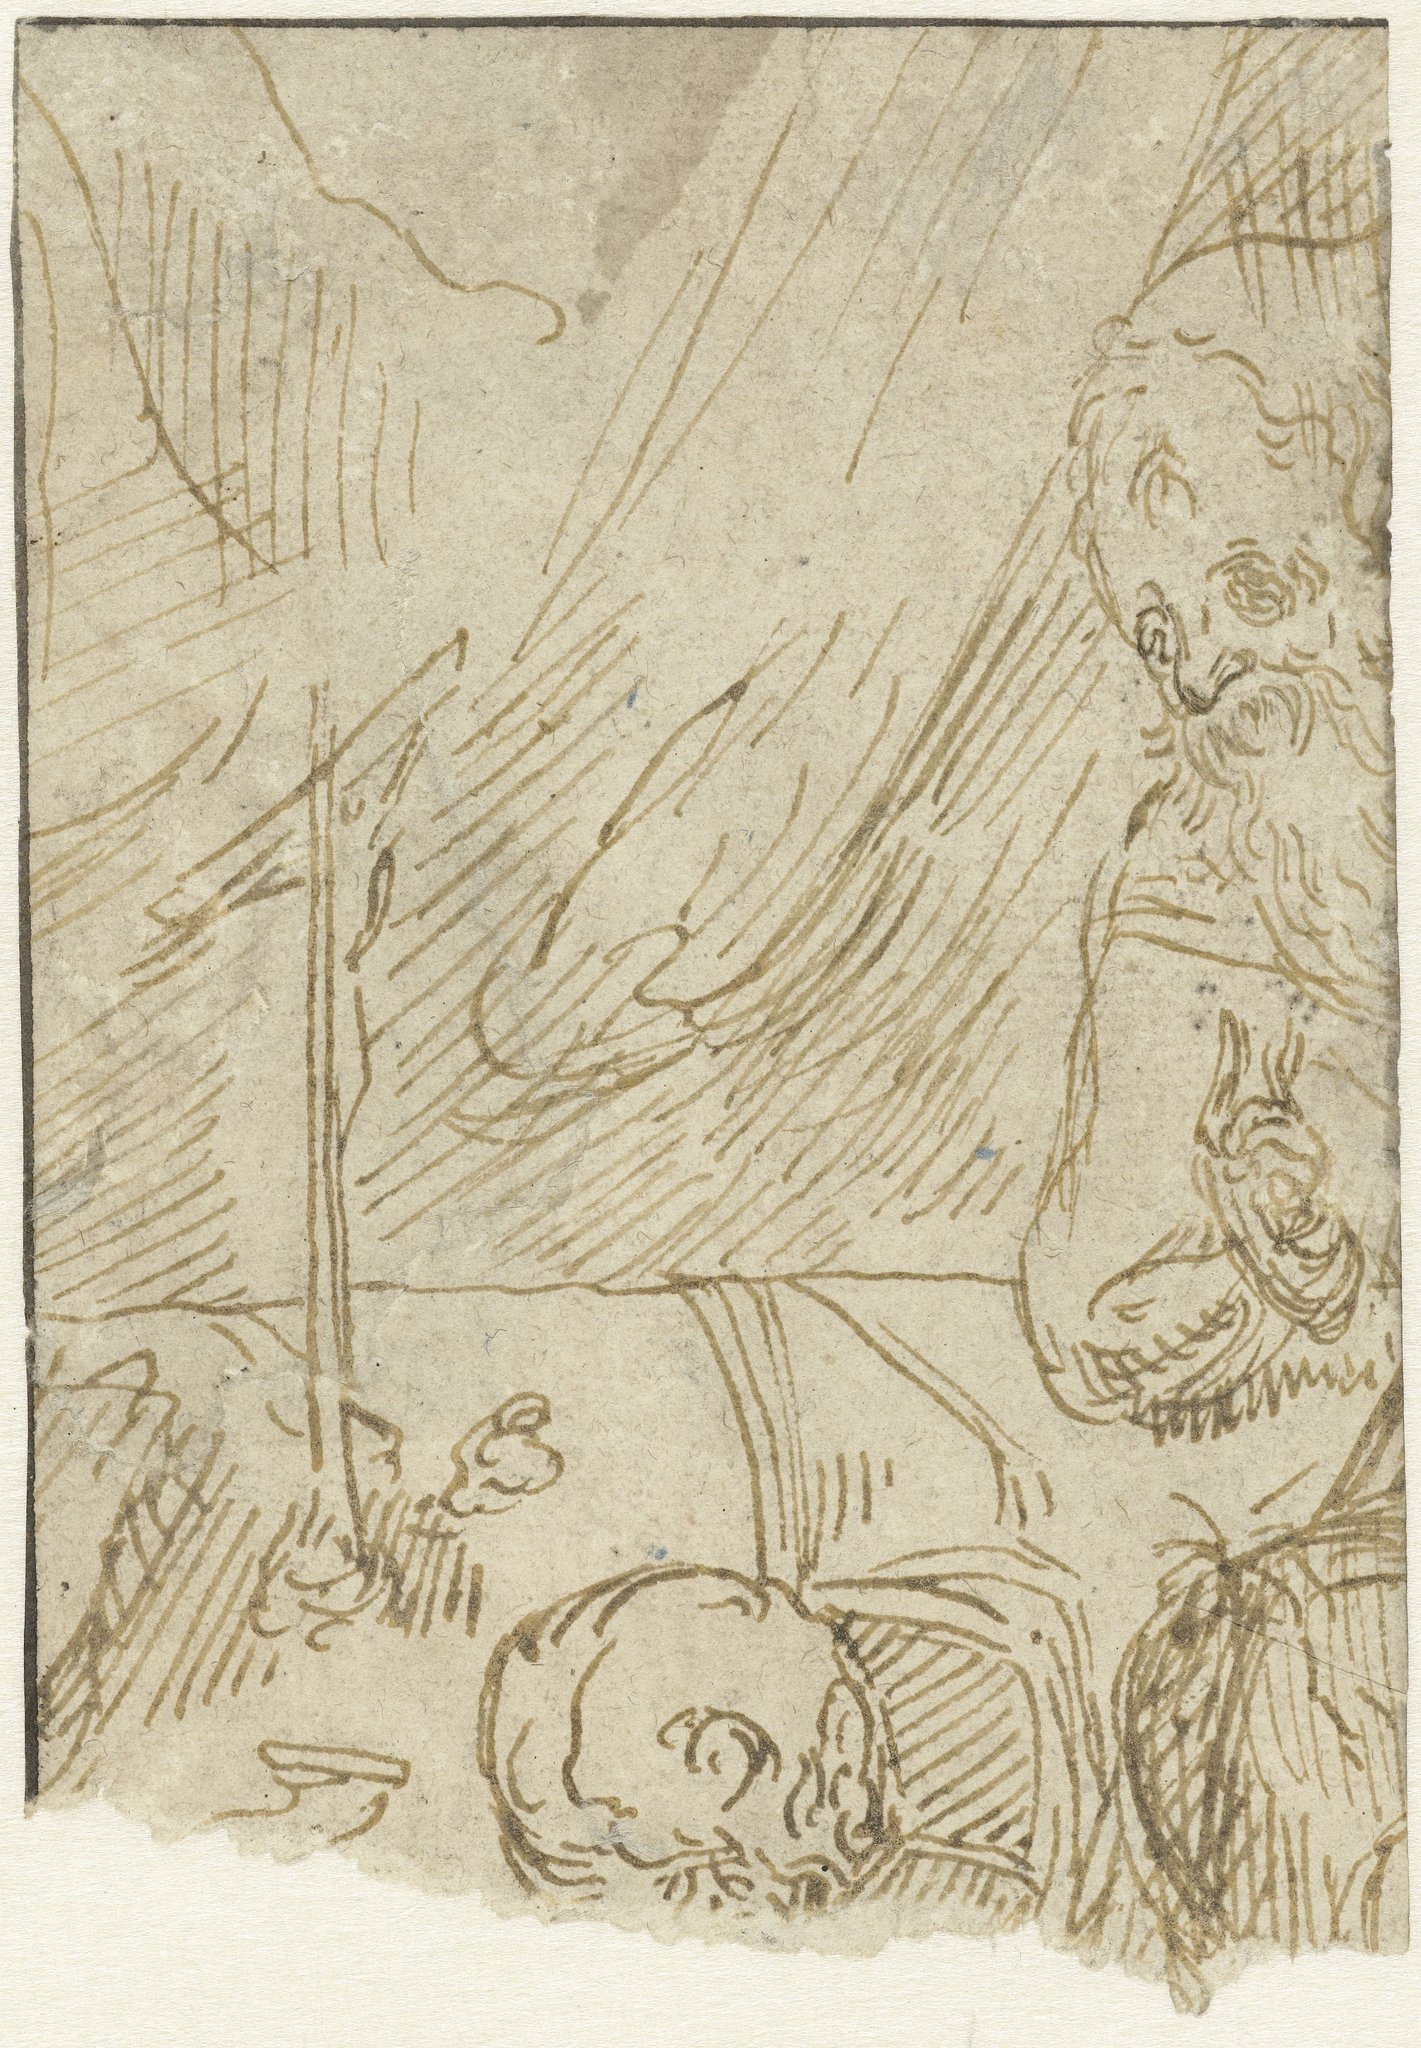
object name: drawing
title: Fragment van een tekening voorstellende de heilige Hieronymus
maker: domenico campagnola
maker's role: draughtsman, painter, print maker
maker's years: 1500-1564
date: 1510-1564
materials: ink, paper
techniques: pen